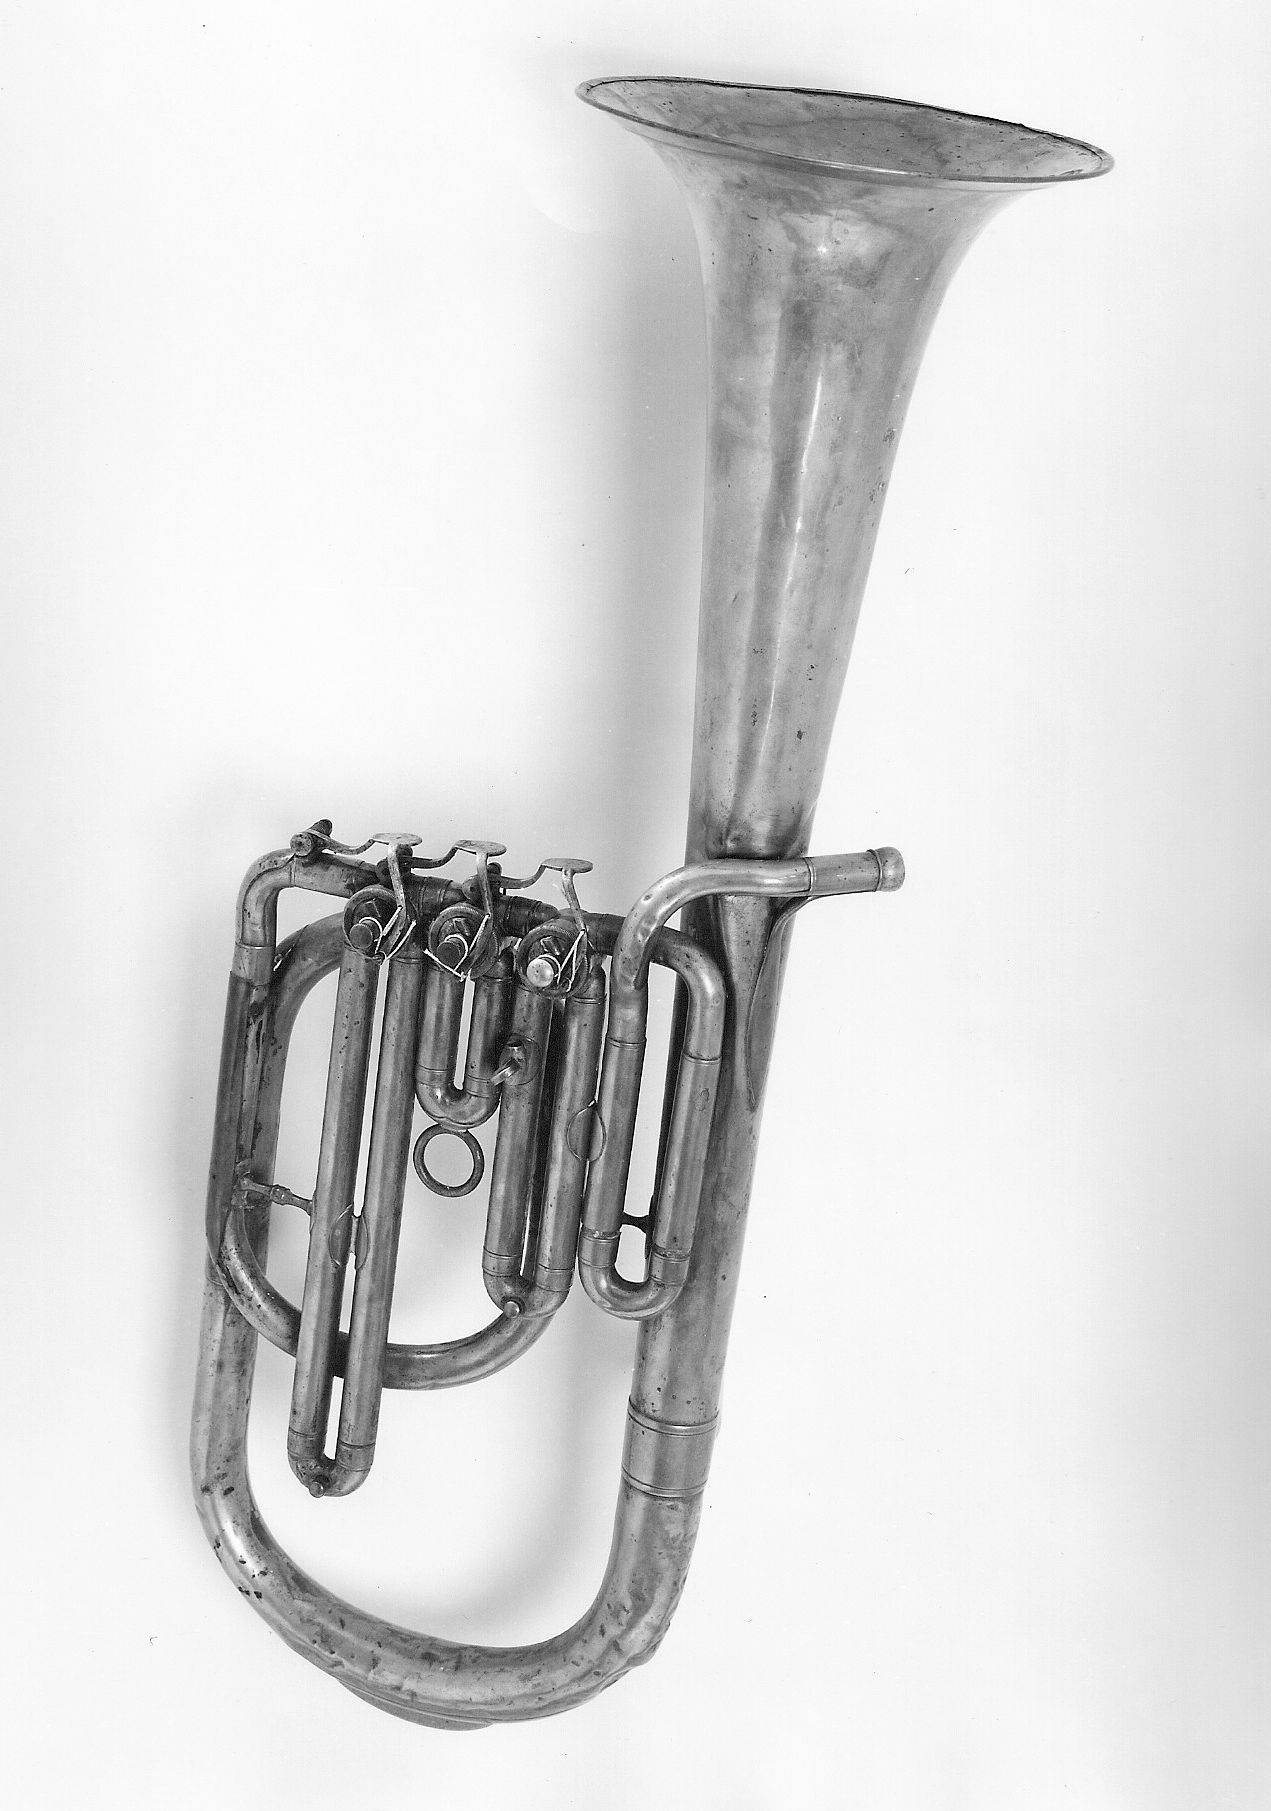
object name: alto saxhorn in e flat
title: Alto Saxhorn in E-flat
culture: american or german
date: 1850-1875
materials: brass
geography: united states